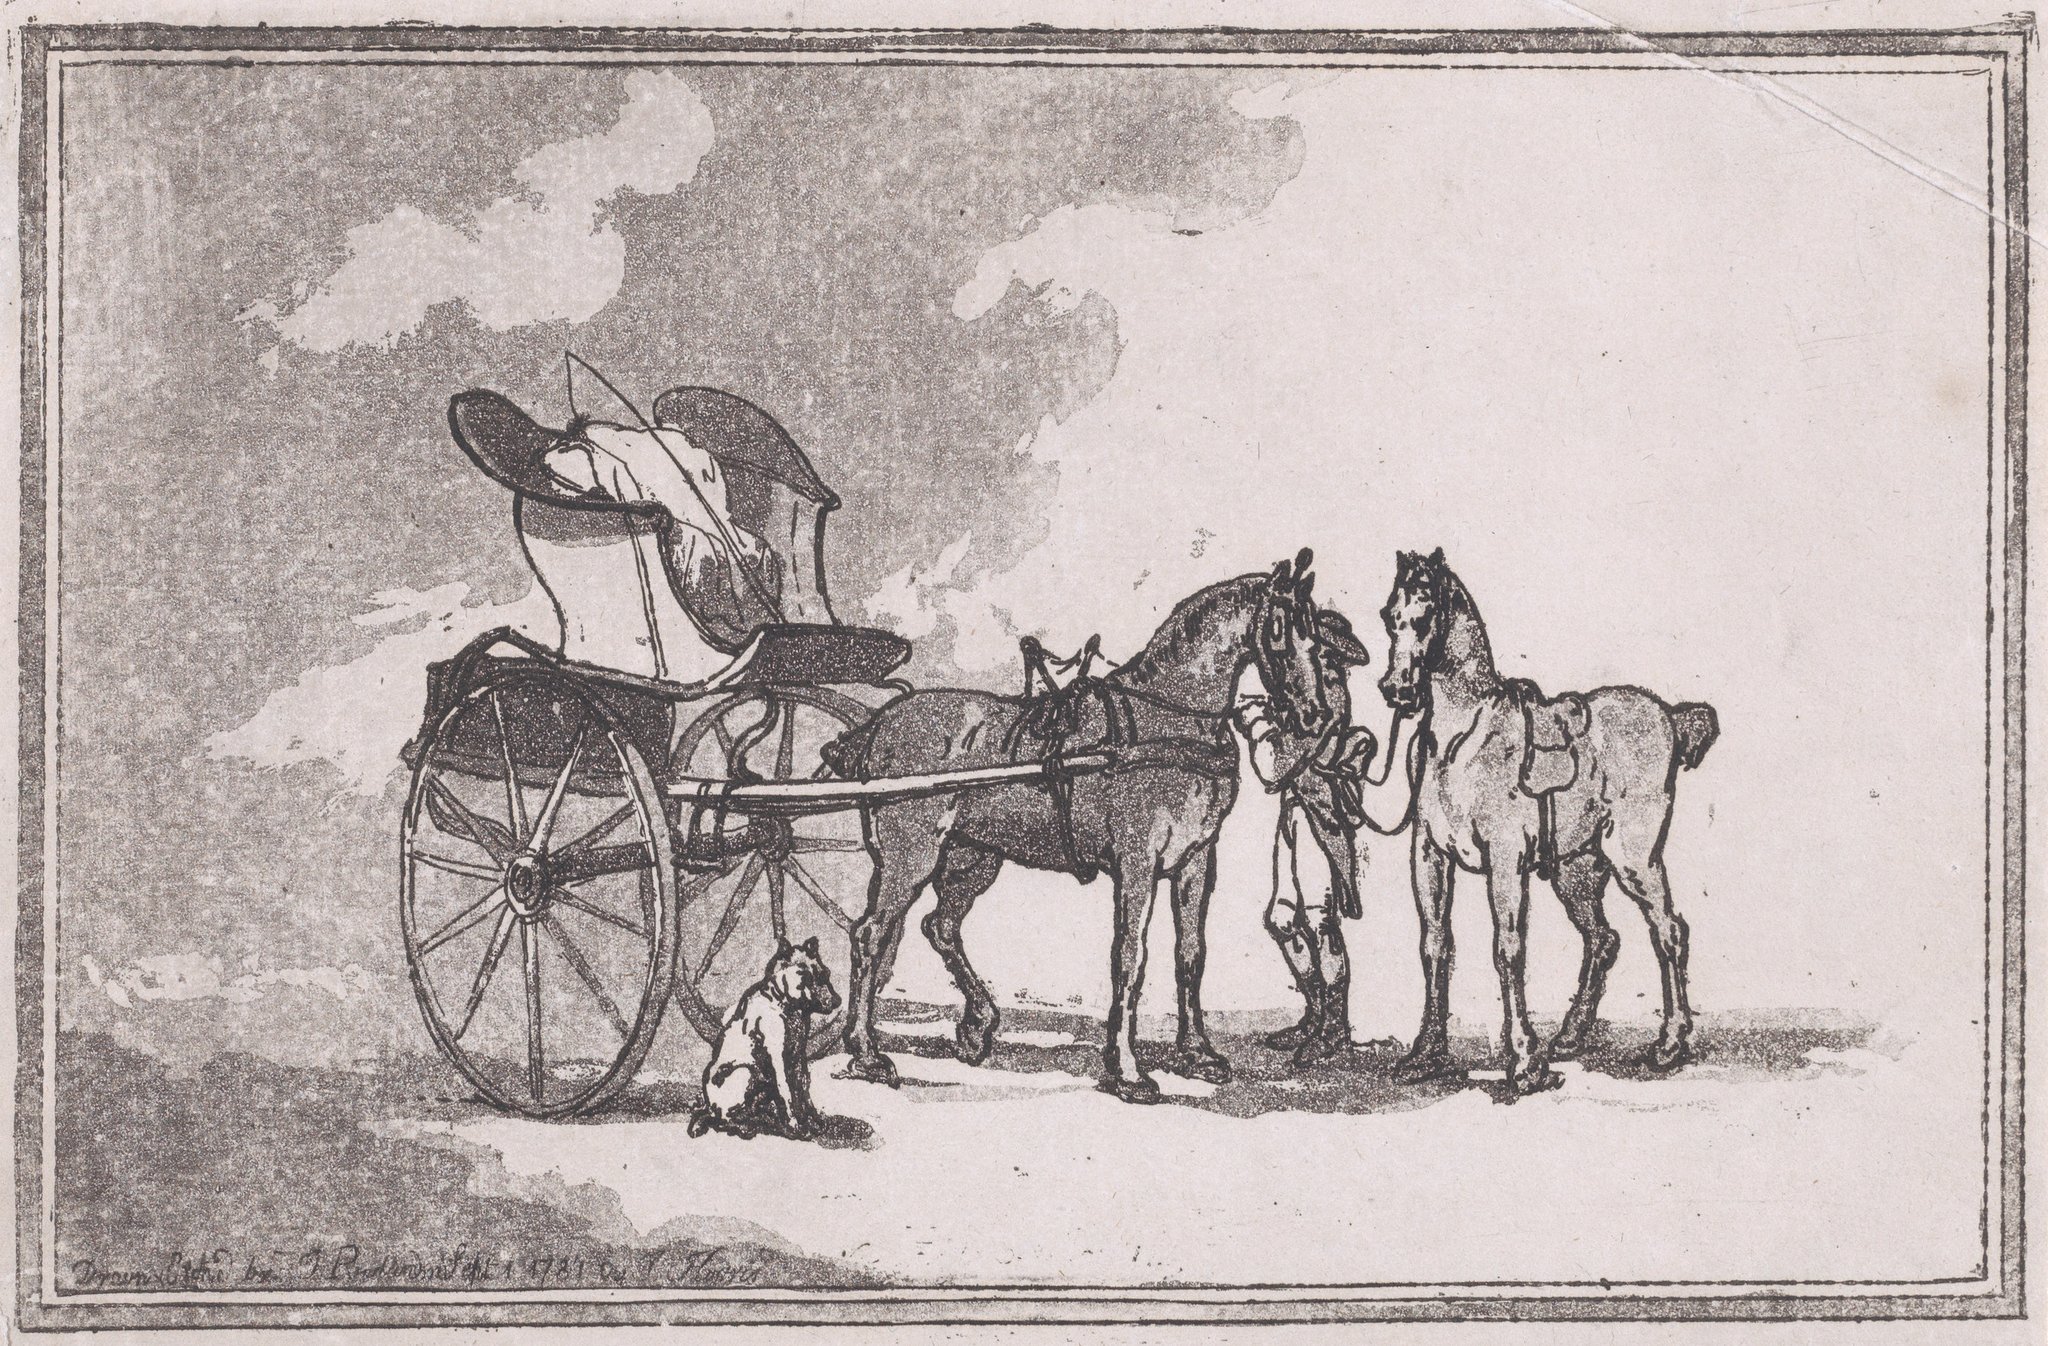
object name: print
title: A Cabriolet or Curricle with a Man Holding Two Horses (A Post Chaise)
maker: thomas rowlandson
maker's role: artist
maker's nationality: british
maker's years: 1757-1827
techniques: aquatint, etching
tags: dogs,horses,carriages